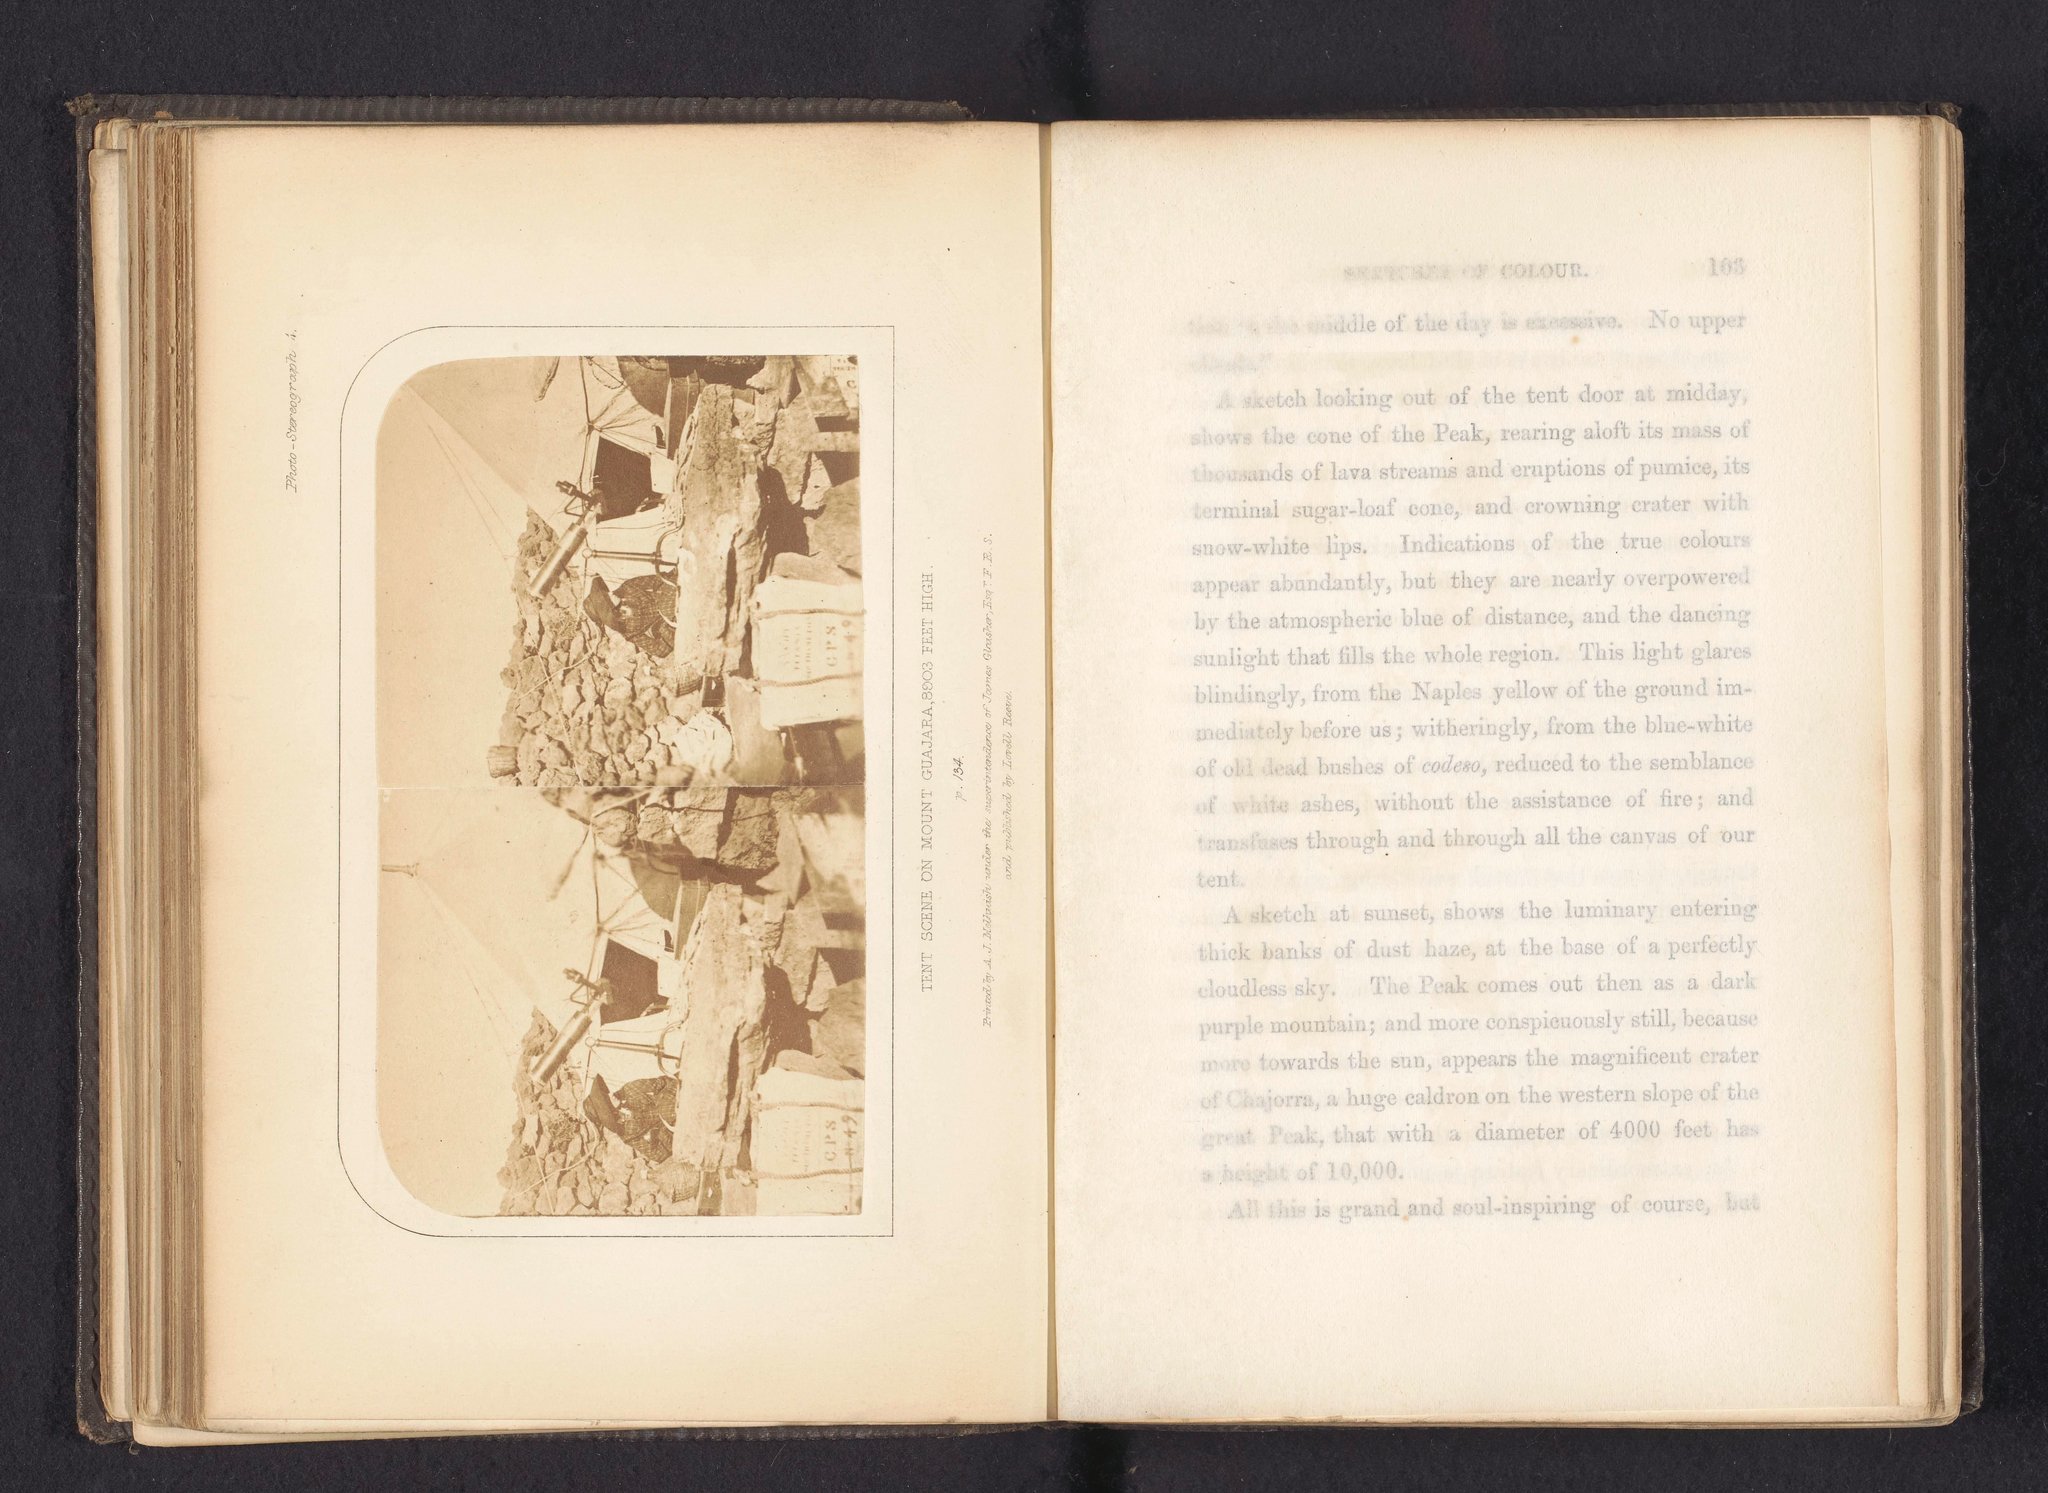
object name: stereograph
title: Tent scene on mount Guajara, 8903 feet high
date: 1881-1886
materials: photographic support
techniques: albumen print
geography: guajara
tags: tent-camp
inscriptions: number: ‘Photo-stereograph 4.’